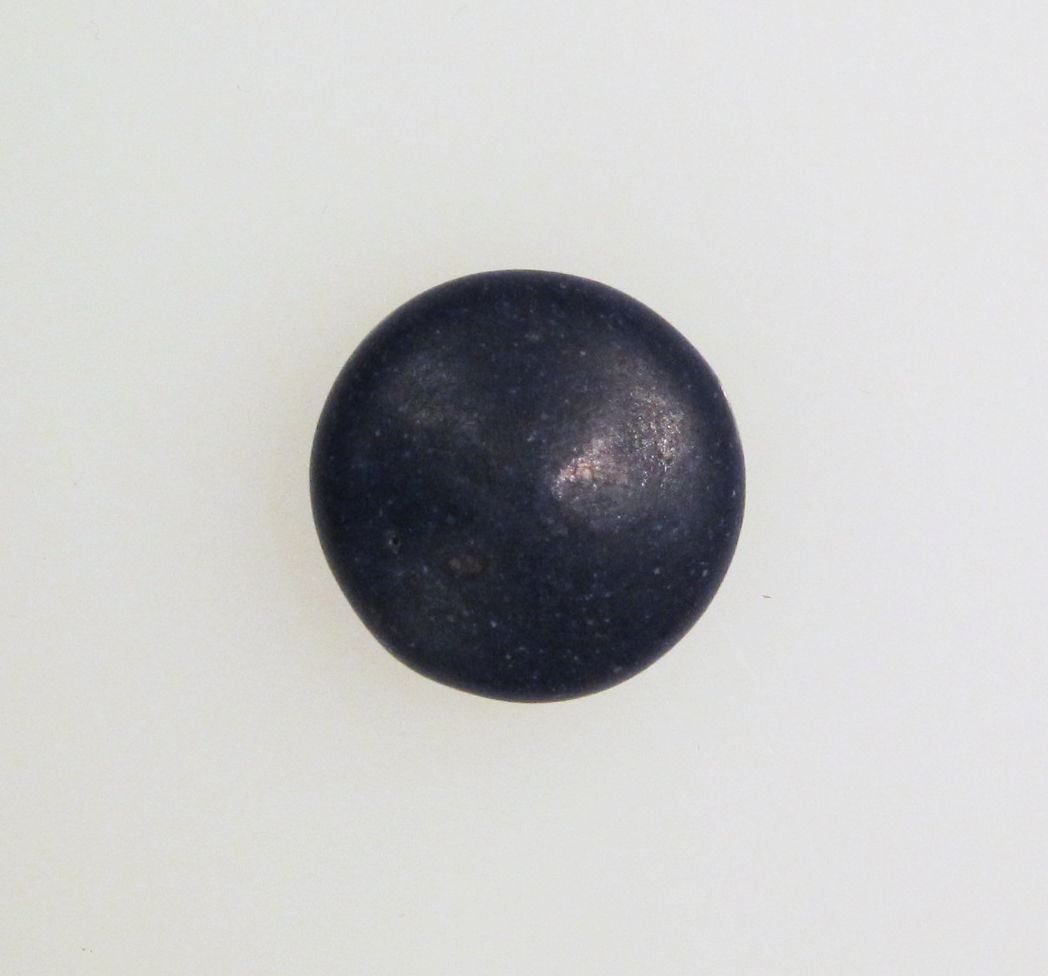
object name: pinhead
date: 7000 BCE-330 CE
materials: glass